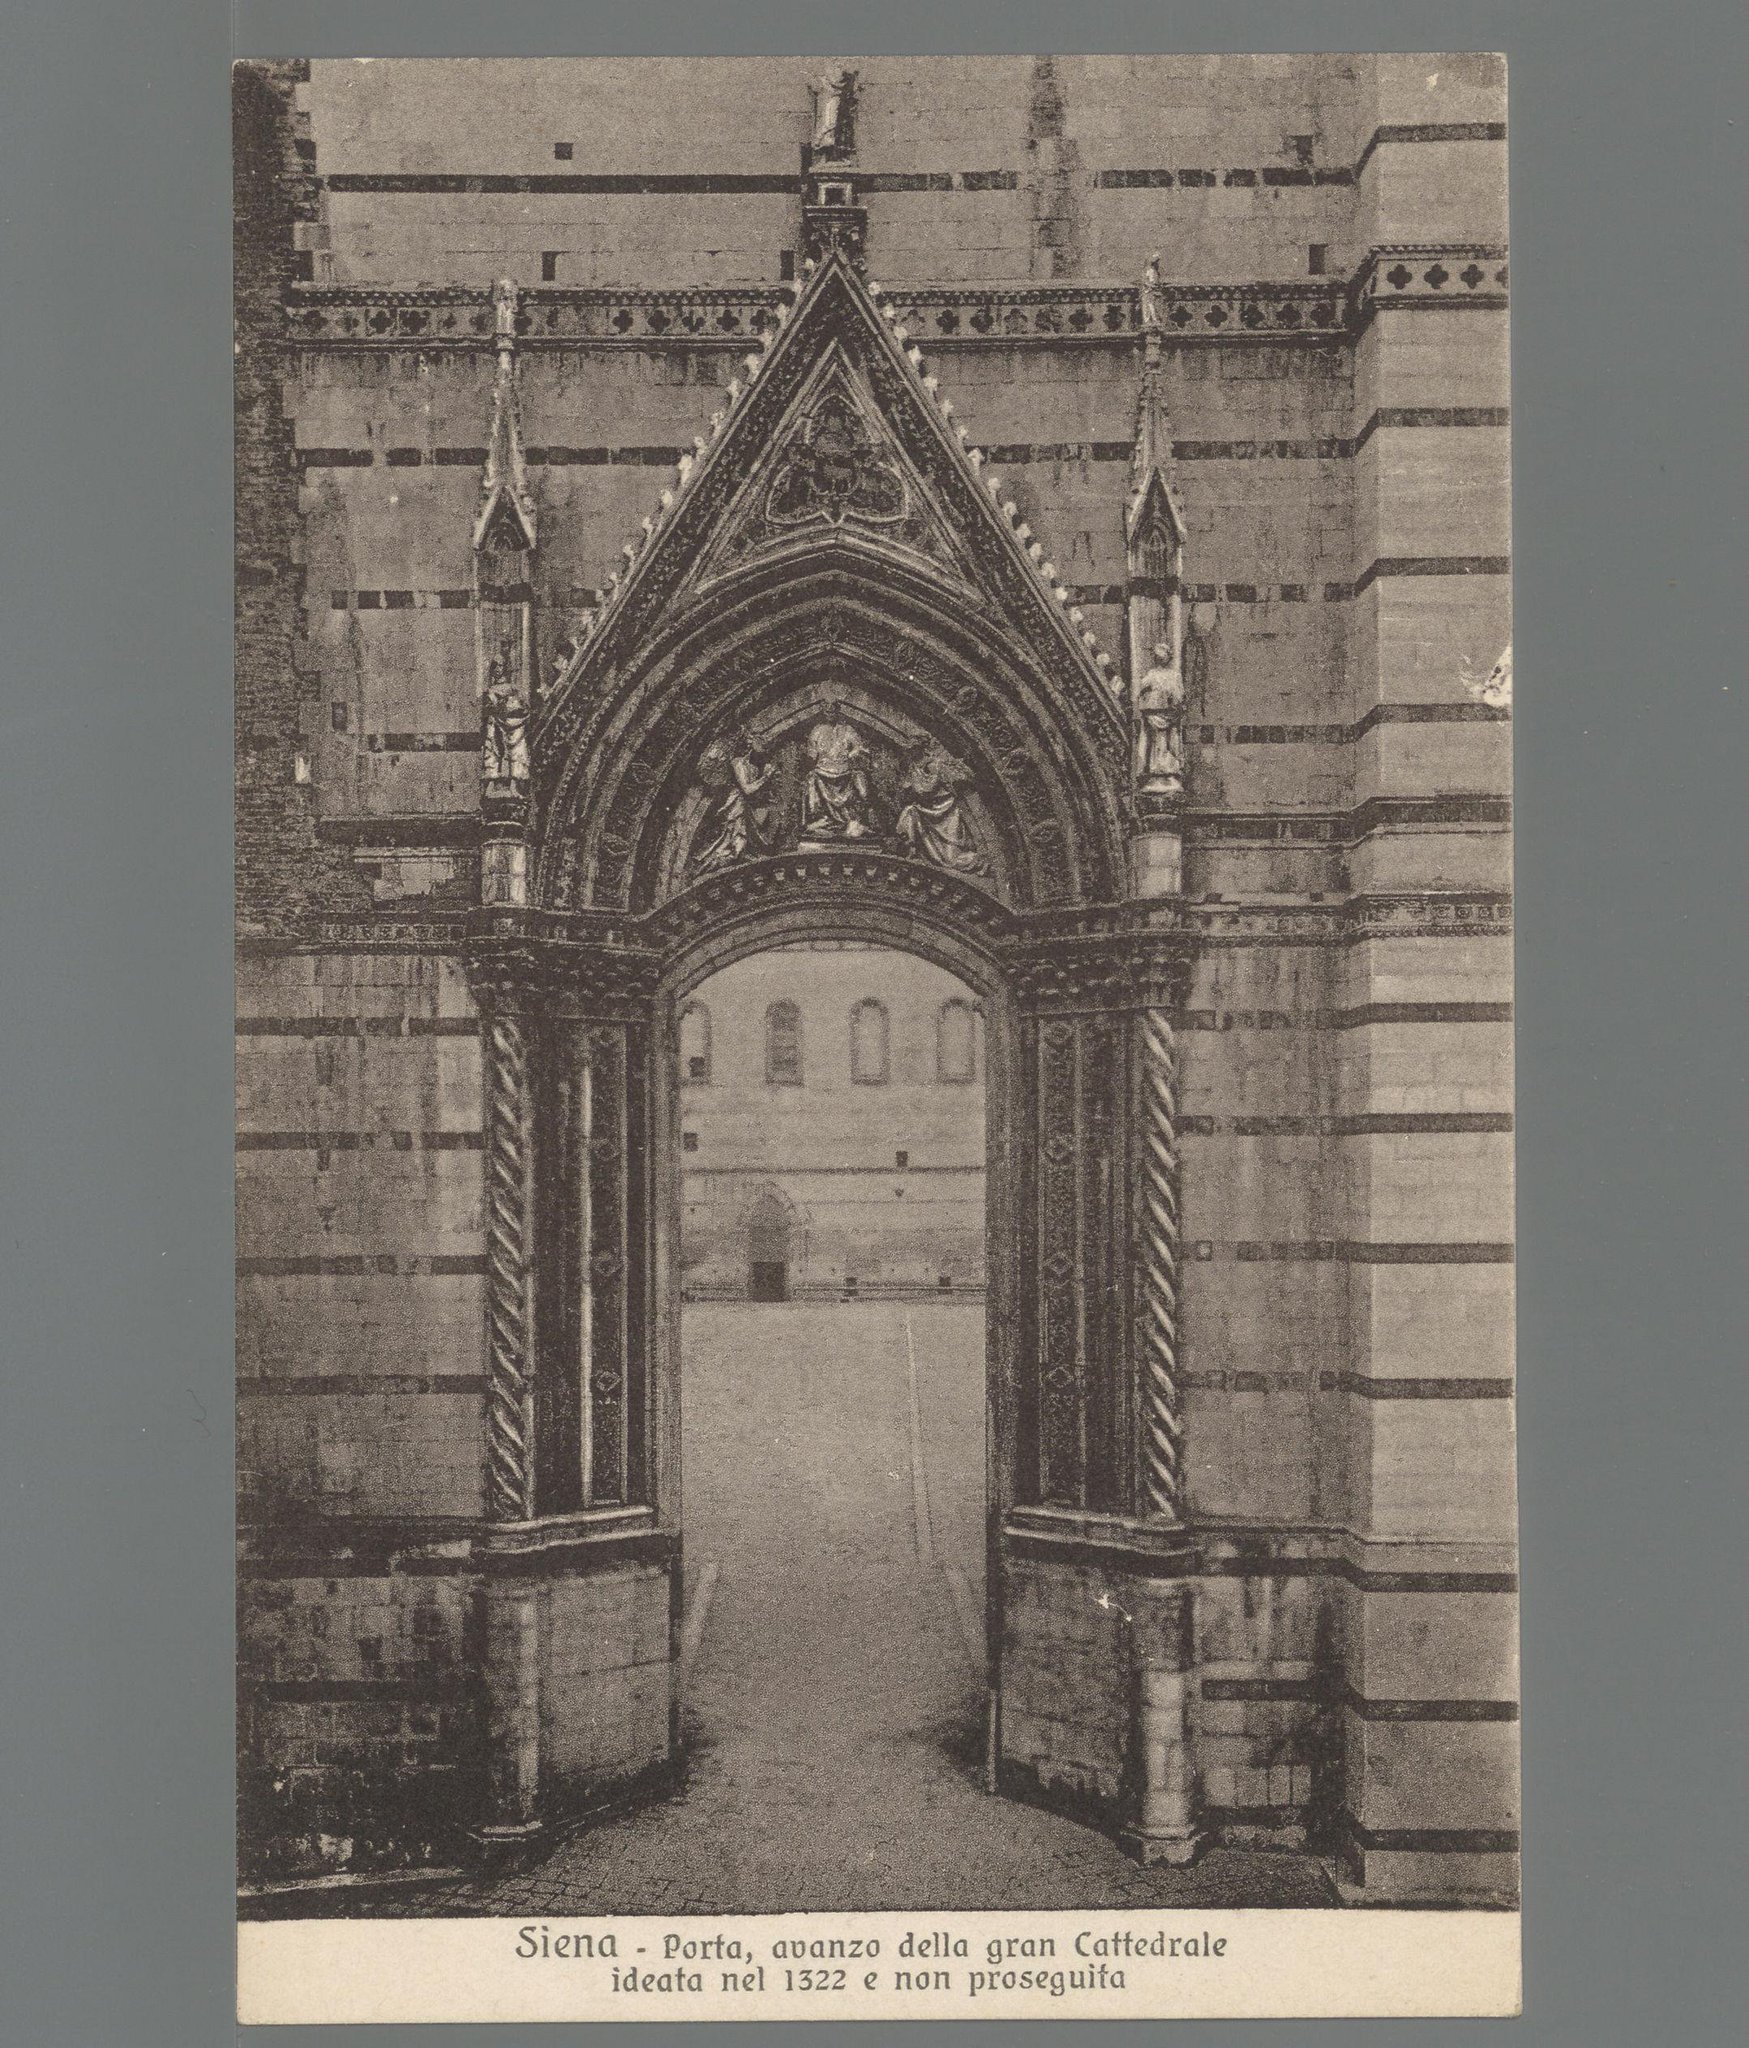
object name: photomechanical print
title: Siena. Porta, avanza della gran Cattedrale, ideata nel 1322 e non proseguita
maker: Anonymous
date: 1906-1930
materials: cardboard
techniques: photograph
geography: siena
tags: parts of church exterior and annexes: portal